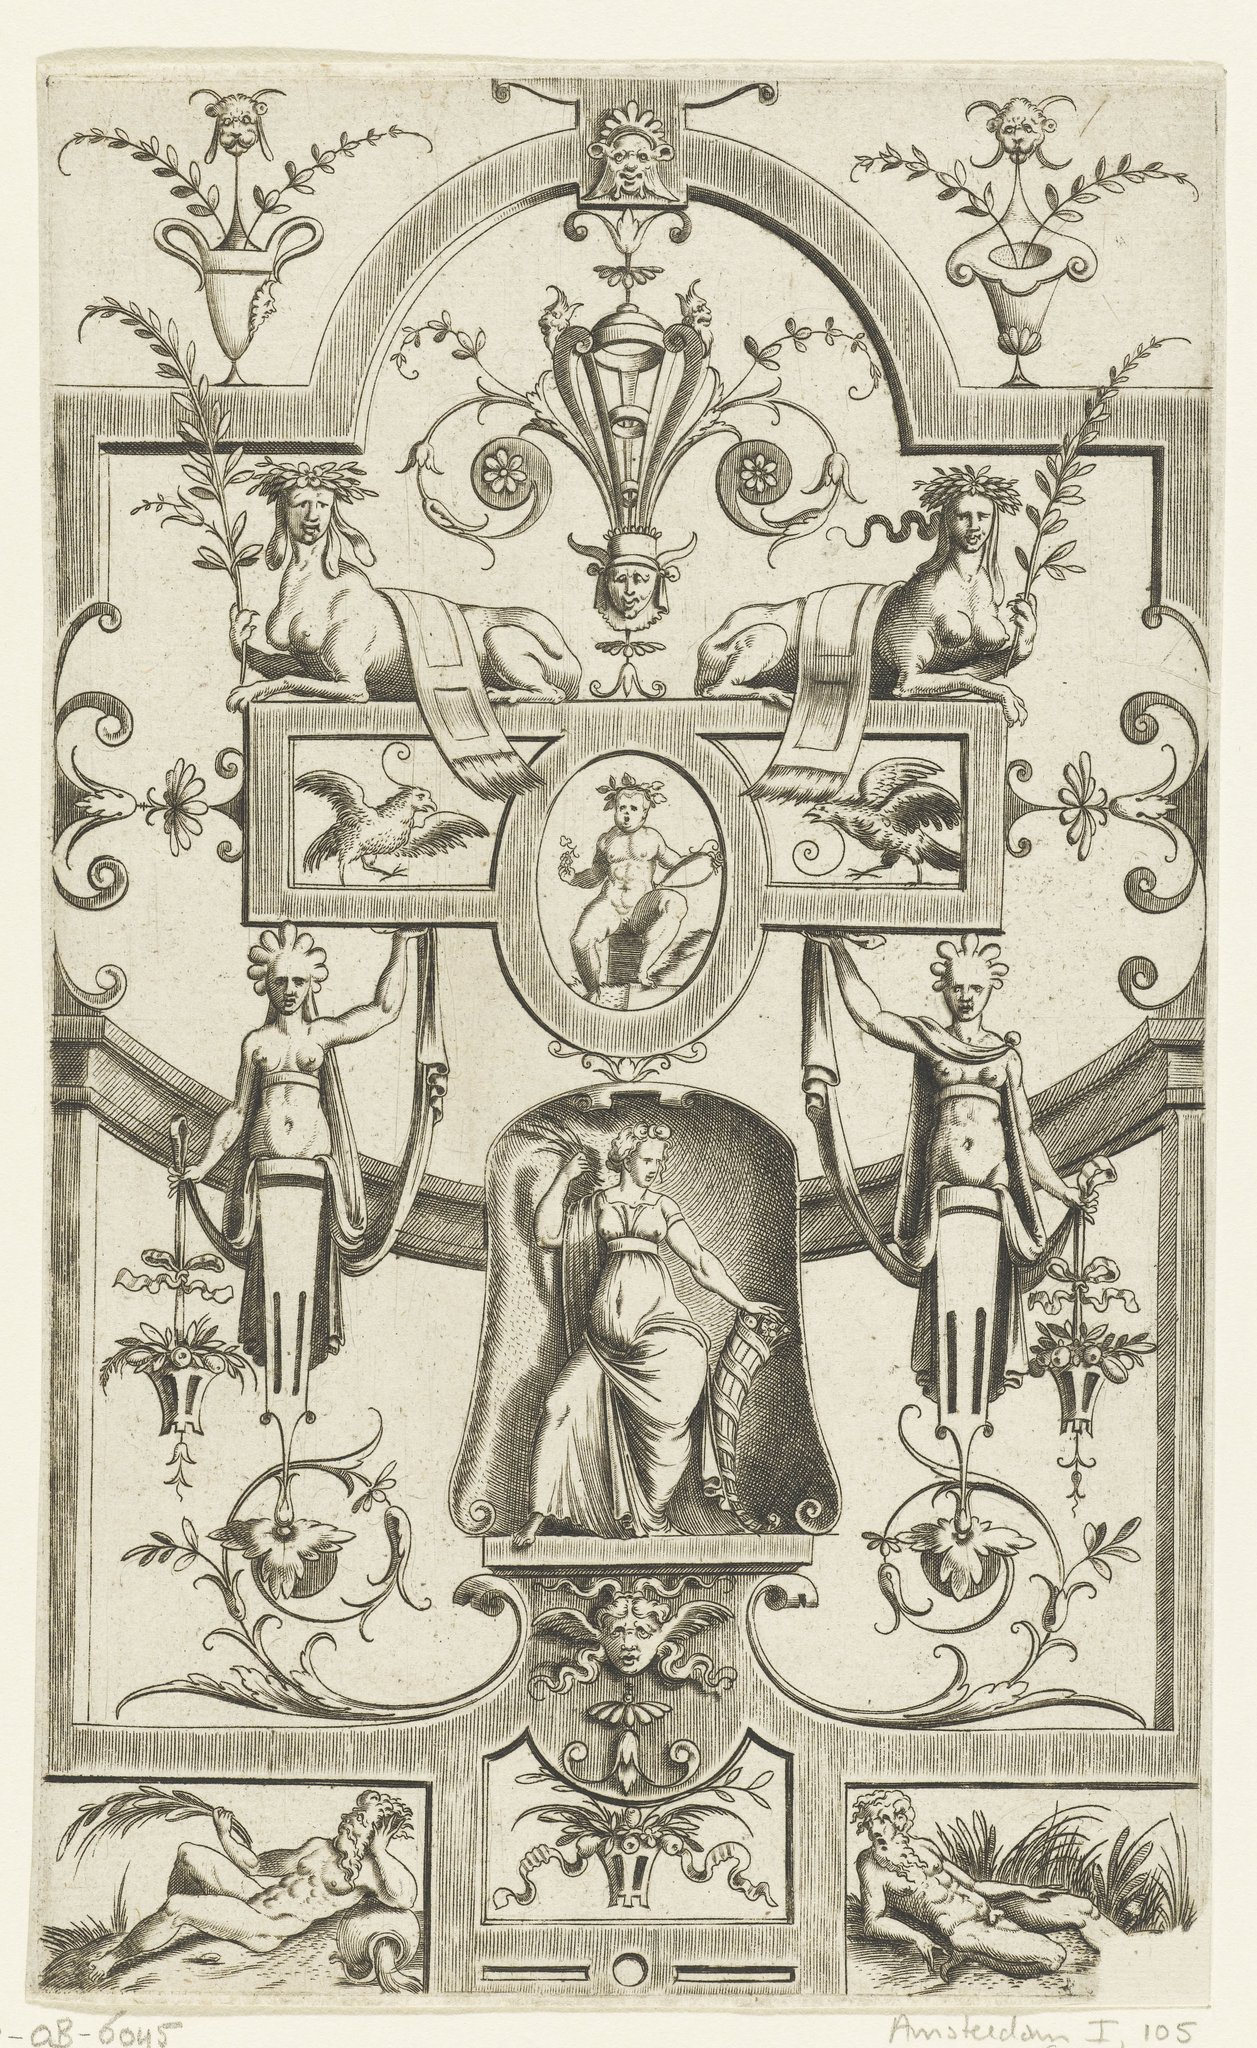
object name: print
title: Vlakdecoratie met grotesken, in het midden staat Ceres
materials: paper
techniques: engraving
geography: netherlands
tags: (story of) ceres (demeter), (story of) bacchus (dionysus), liber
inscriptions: inscription: ‘Hollandais 16e J(?)’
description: Ceres staat in een nis. Twee vrouwelijke hermen ter weerszijden van de nis houden een cartouche omhoog waarin Bacchus zit, geflankeerd door twee vogels.